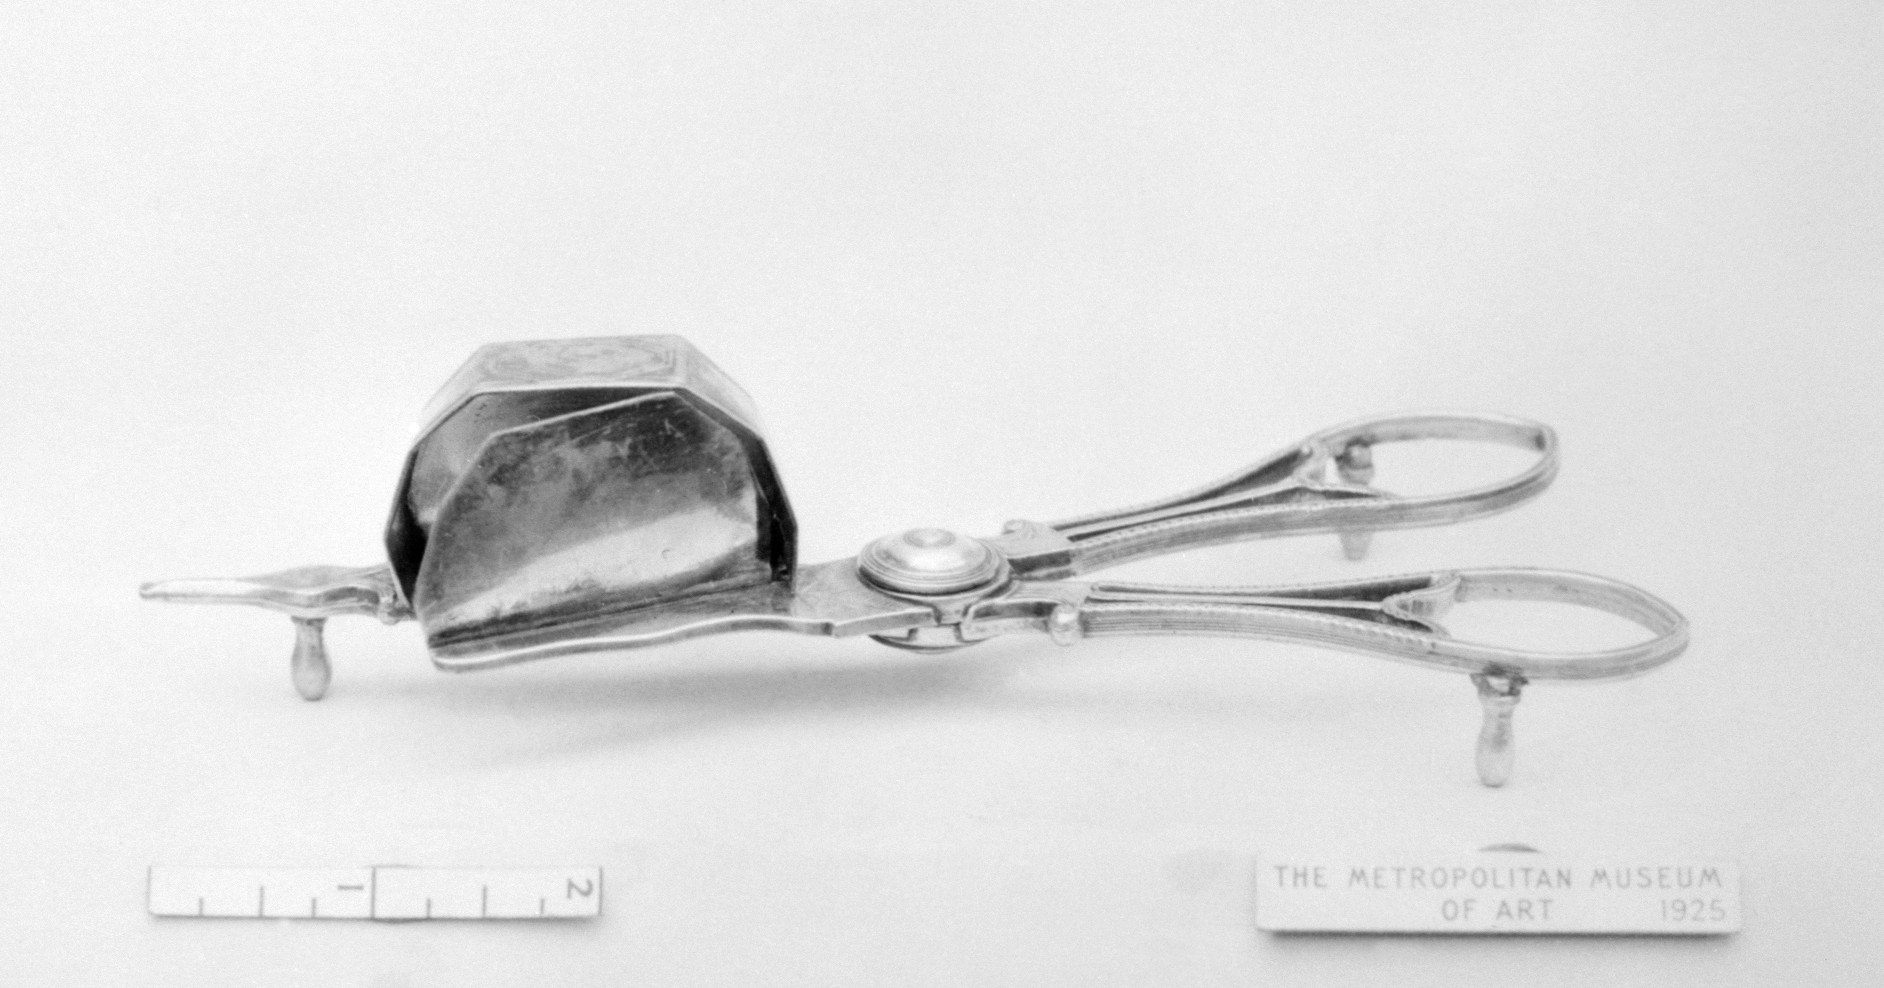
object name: snuffer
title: Snuffers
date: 1780-1790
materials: metal